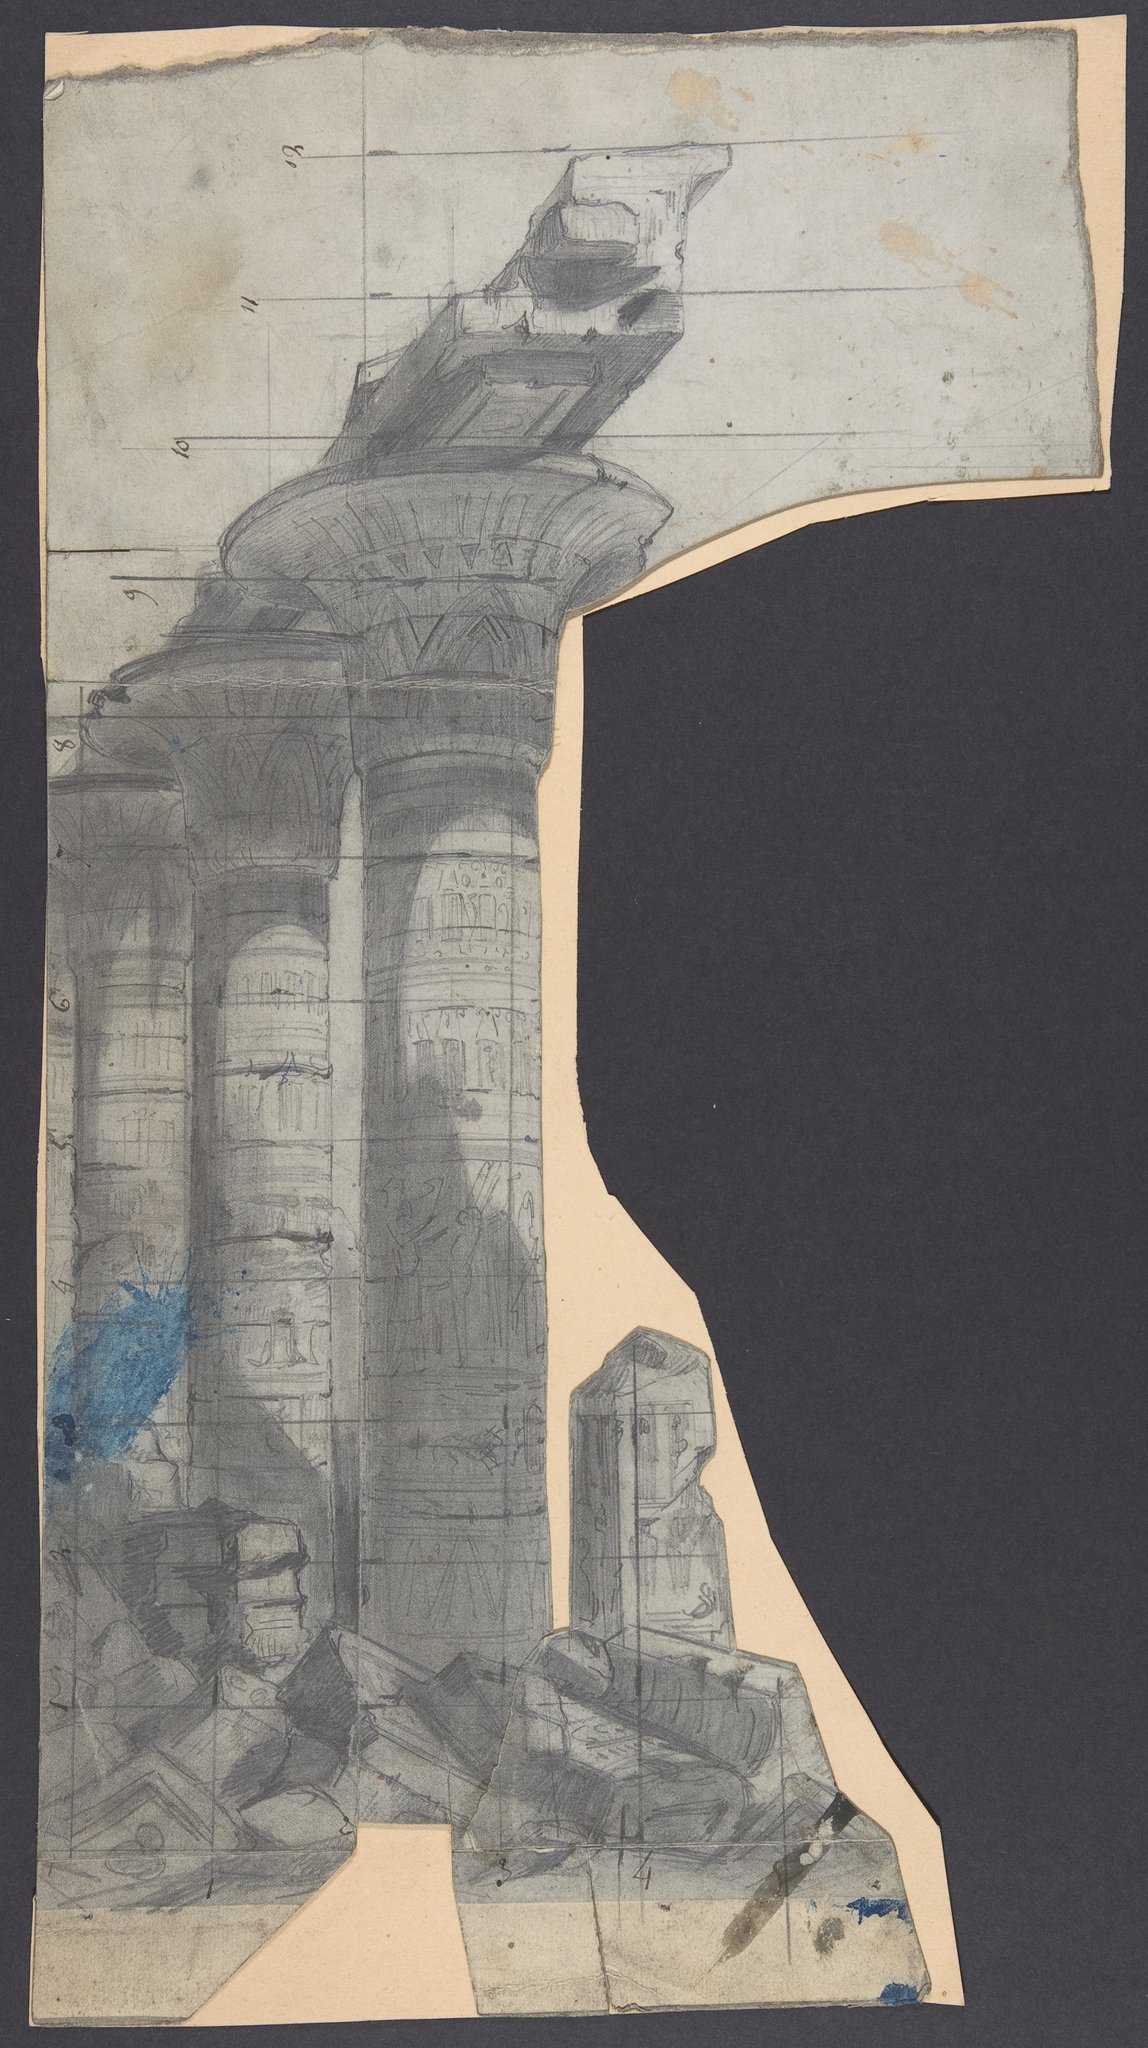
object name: drawing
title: Design for a Stage Set at the Opéra, Paris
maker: eugène cicéri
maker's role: artist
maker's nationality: french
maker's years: 1813-1890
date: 1830-1890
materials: graphite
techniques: brush, wash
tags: columns,stage design